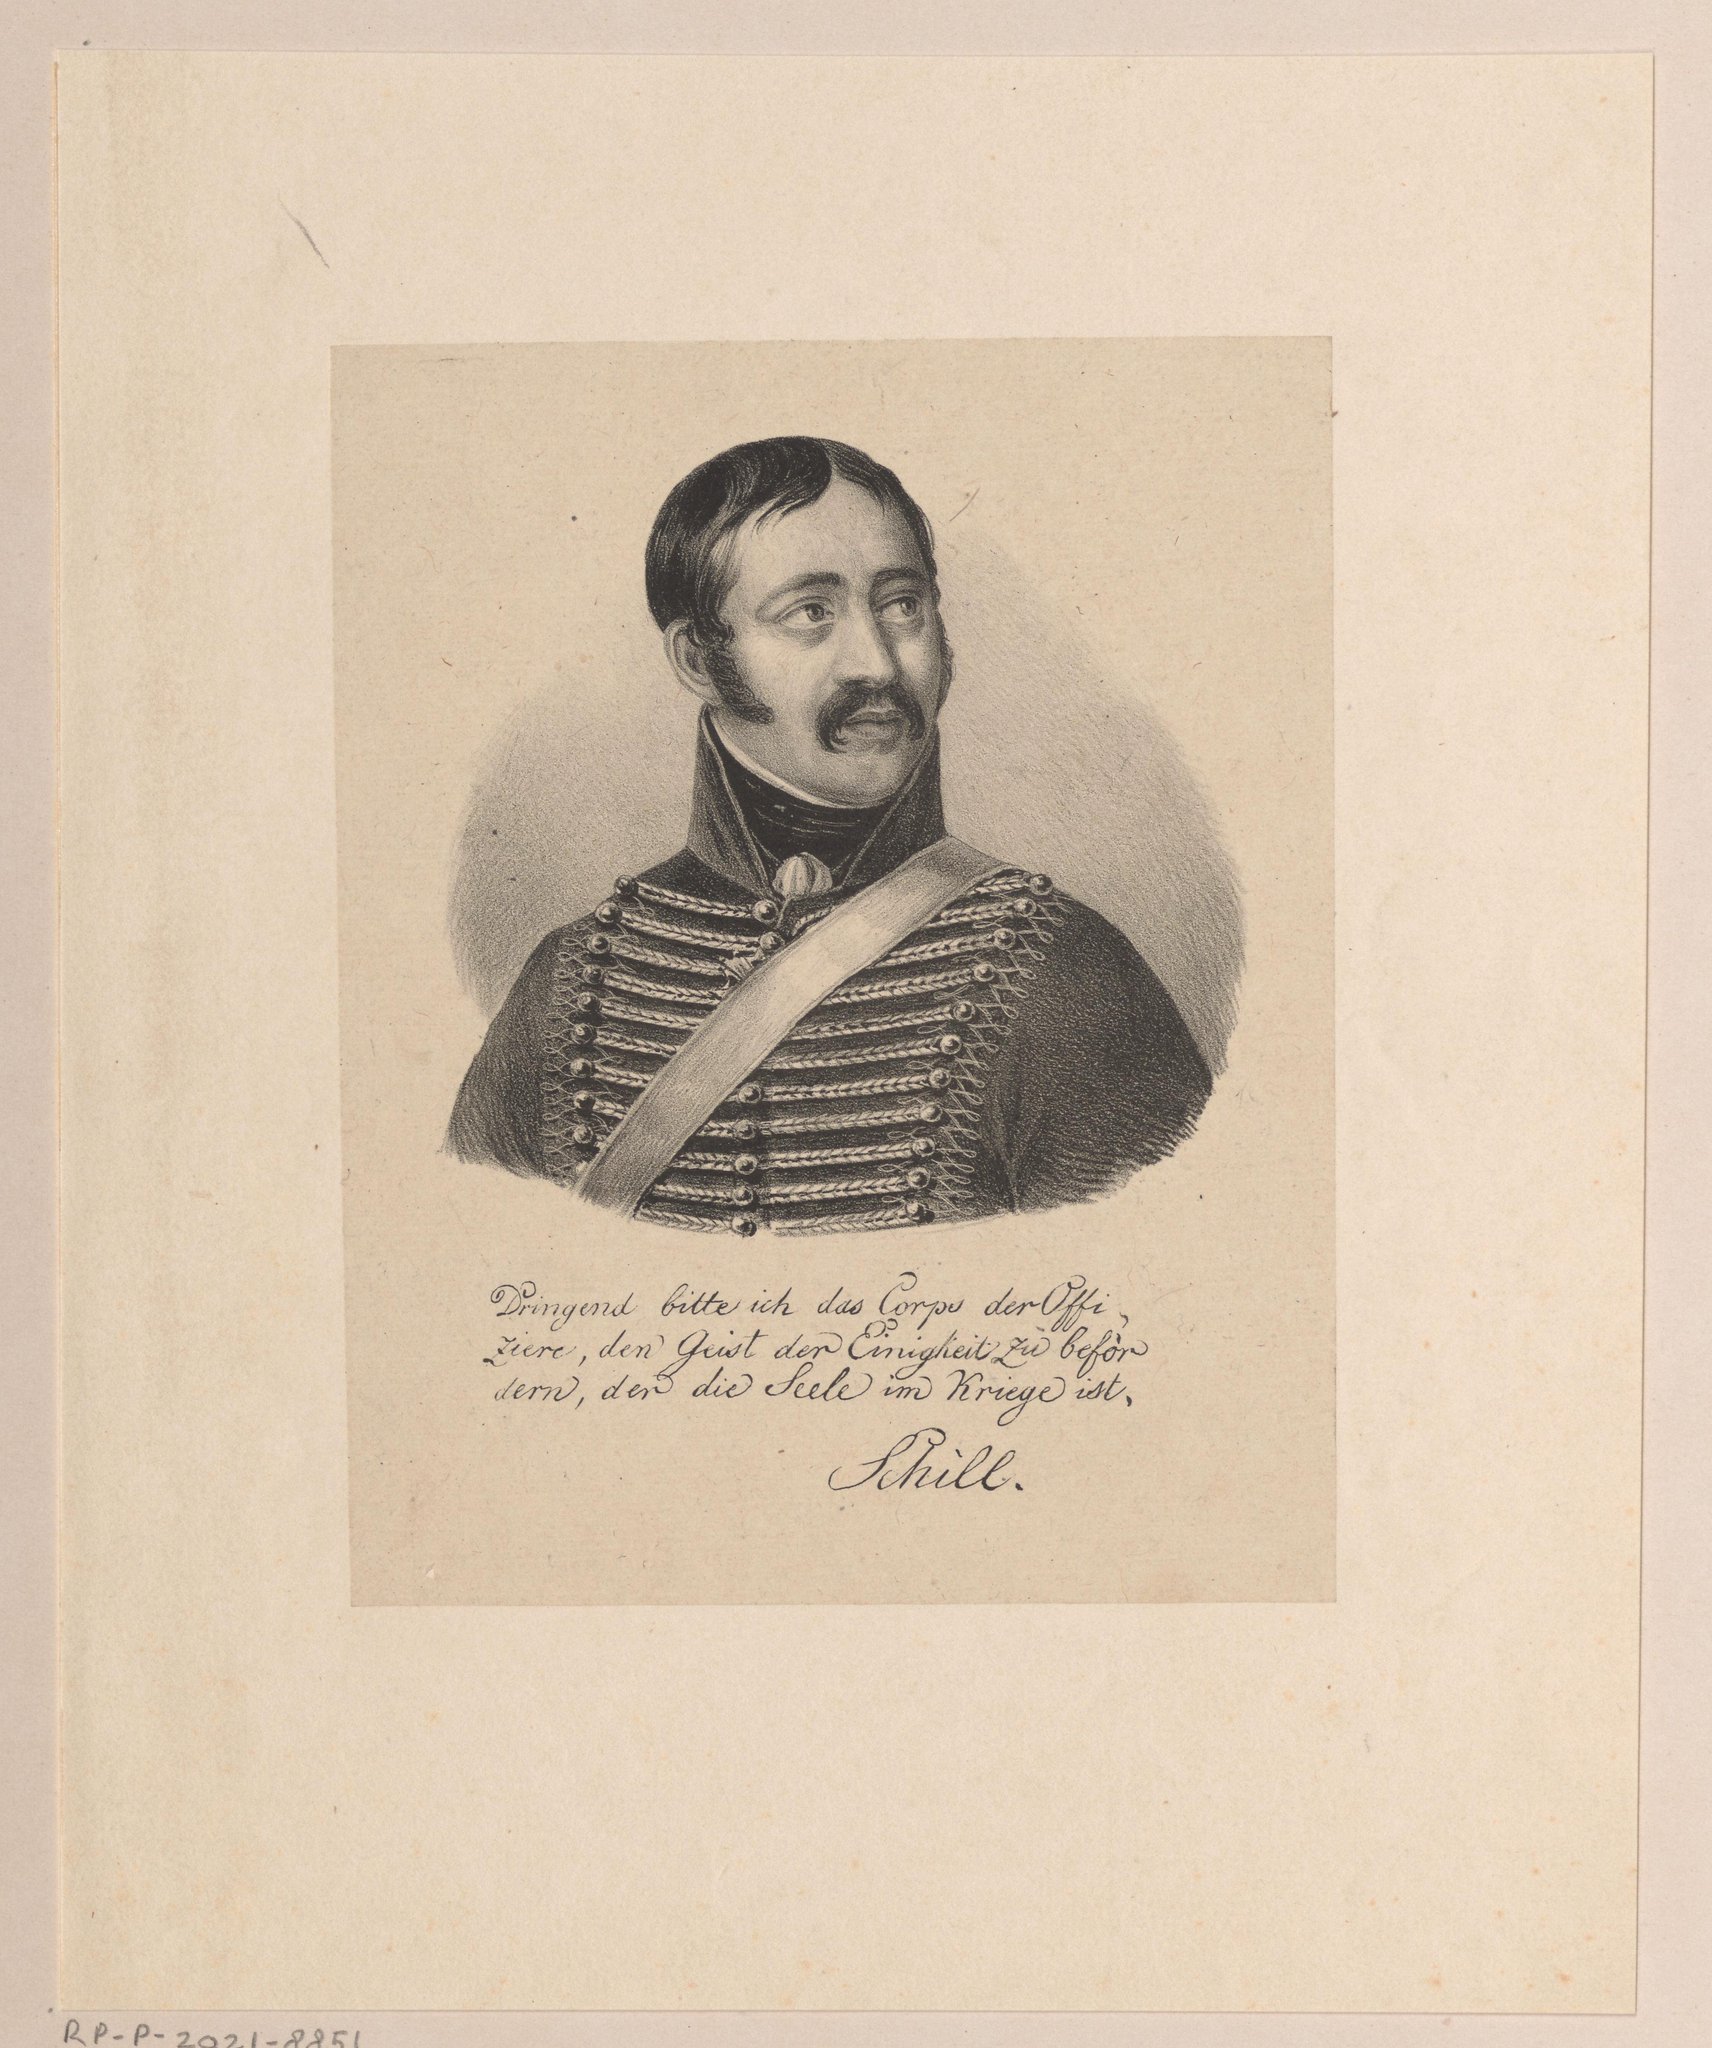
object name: print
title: Portret van Ferdinand von Schill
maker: Anonymous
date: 1838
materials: paper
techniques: lithograph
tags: historical persons, officer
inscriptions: collector's mark: Lugt 2228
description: Prent mogelijk uit: Ferdinand von Schill. Leiden: H.W. Hazenberg & compagnie, 1838.